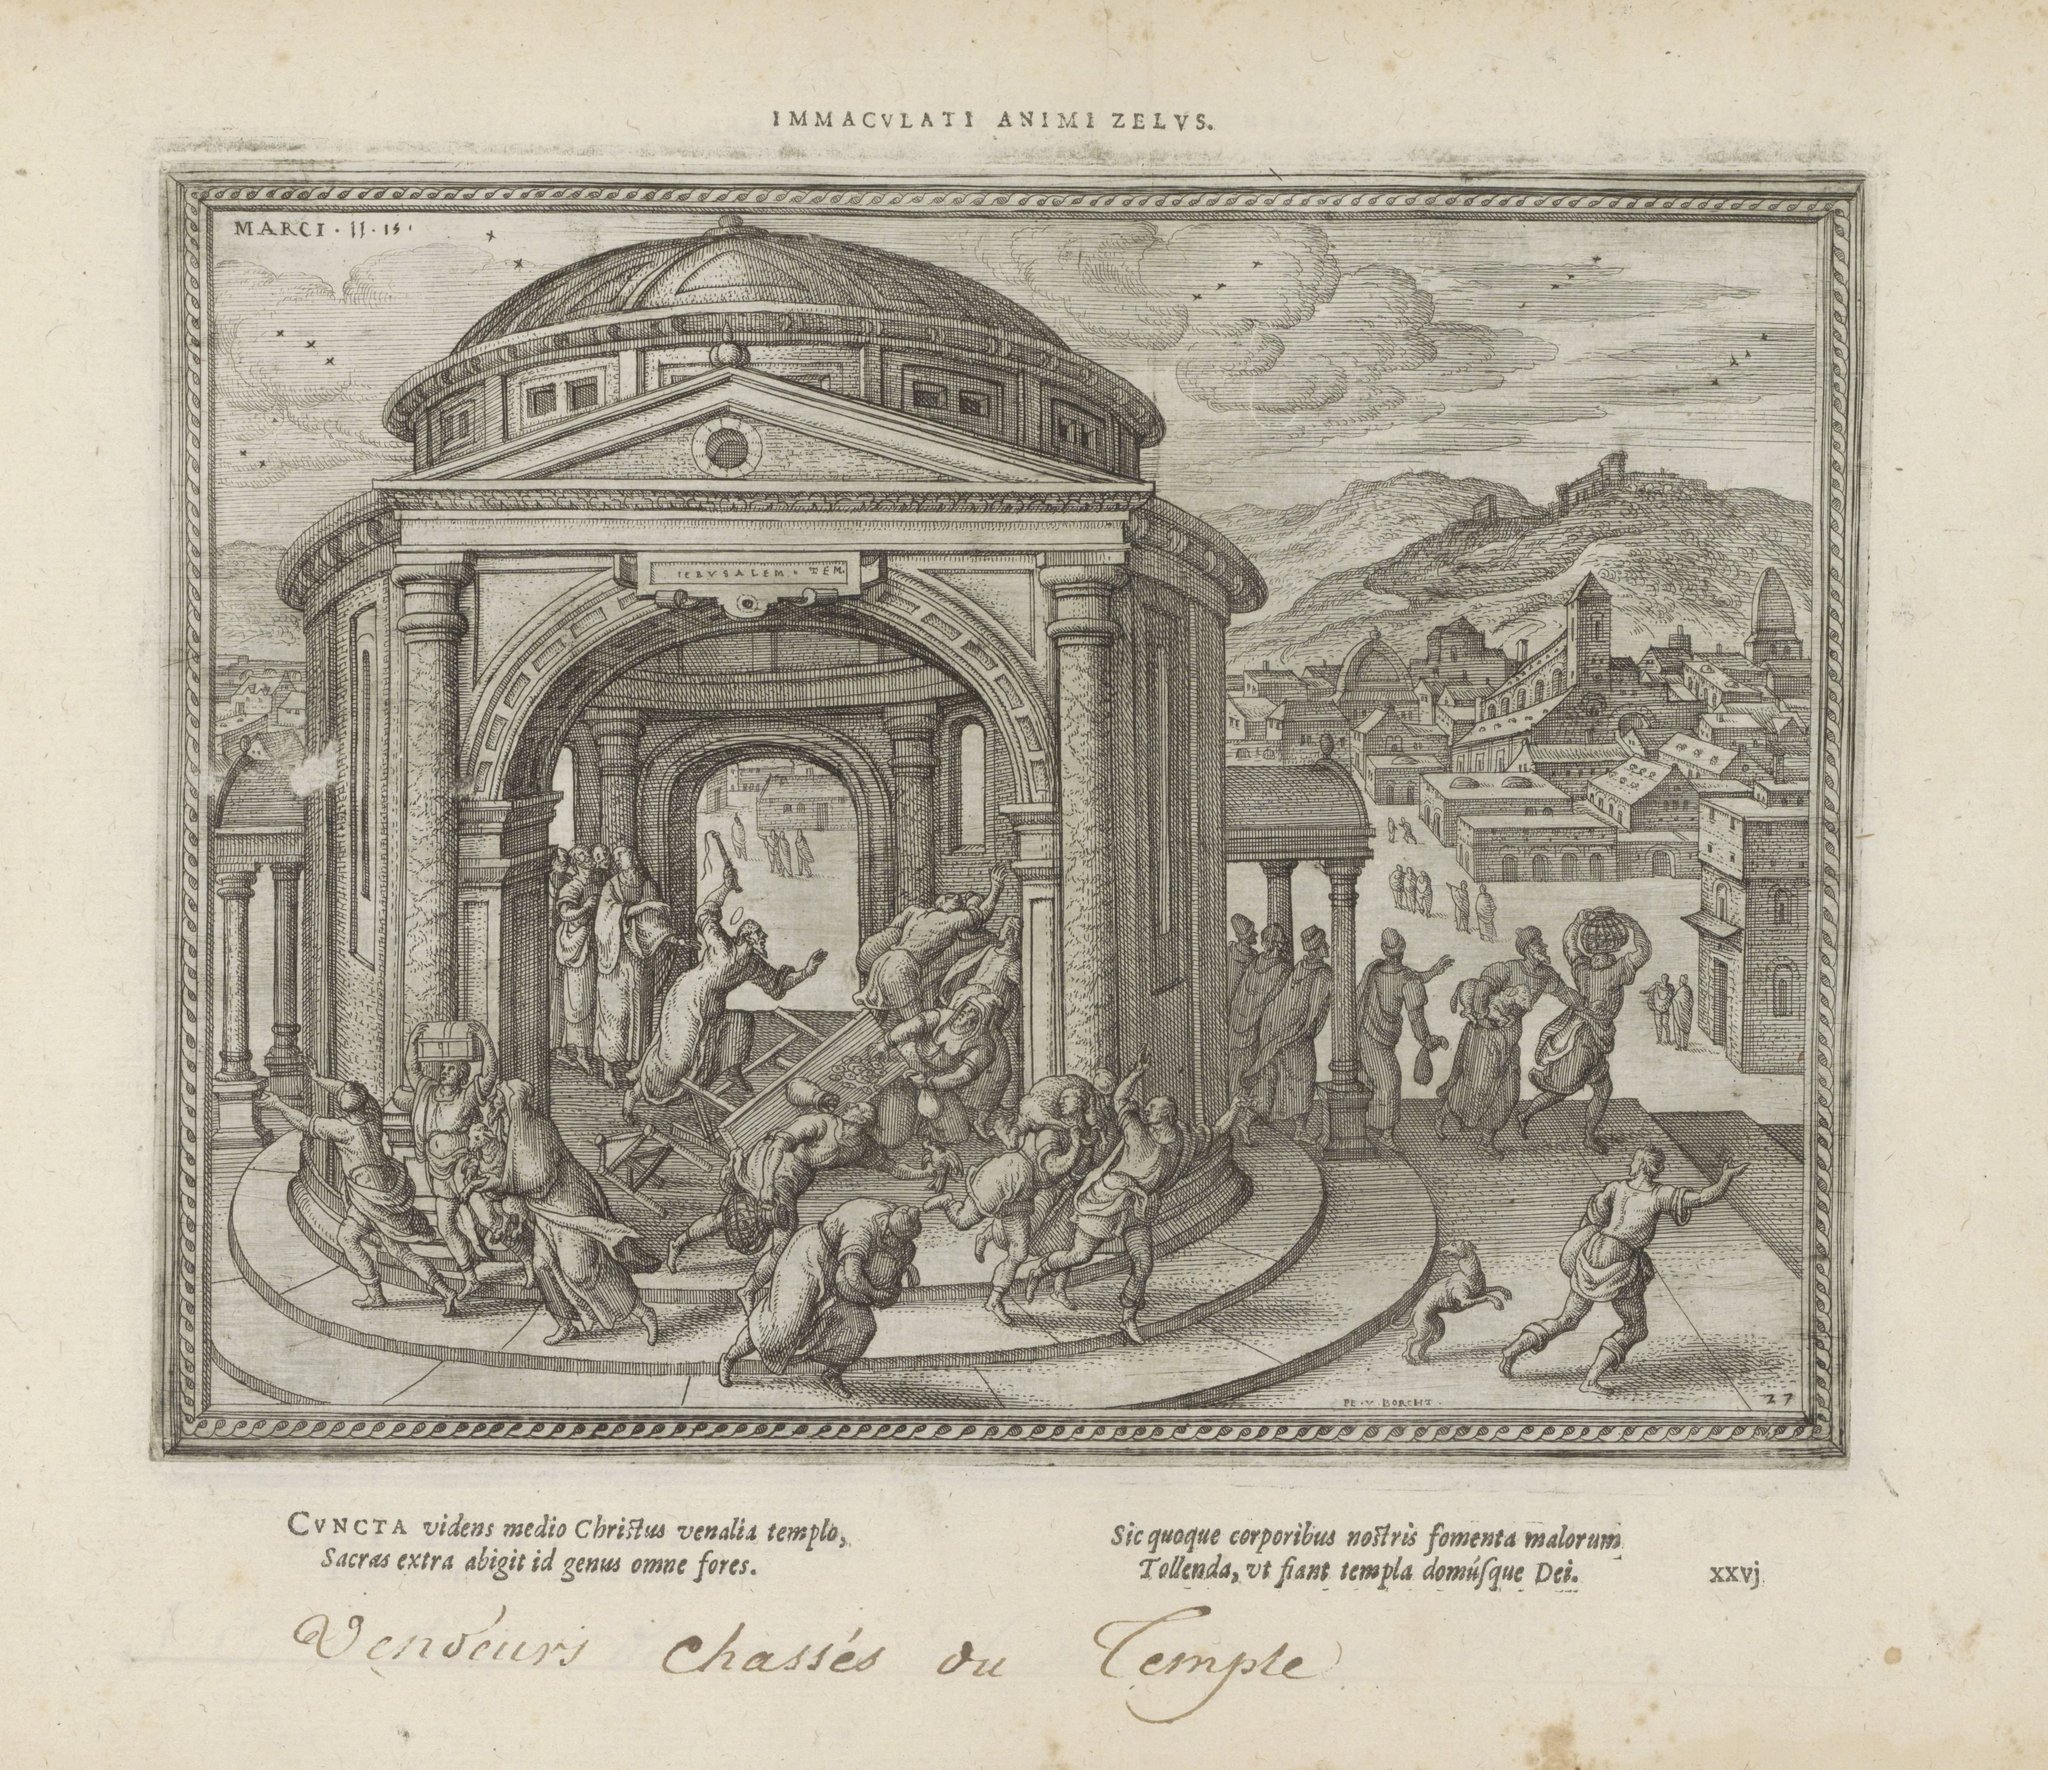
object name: album leaf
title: Imagines et figurae bibliorum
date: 1582-1593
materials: paper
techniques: etching, letterpress printing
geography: amsterdam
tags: purification of the temple ('first' and 'second'): christ driving the money-changers from the temple with a whip (matthew 21:12-13; mark 11:15-17; luke 19:45-46; john 12:12-19)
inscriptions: inscription: ‘Vendeurs chassés du Temple’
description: Christus jaagt met een zweep de geldwisselaars uit de tempel. Hij gooit hun tafels omver. Een man probeert in zijn vlucht nog geld van de tafel te pakken. Anderen vluchten met een schaap of dragen een kooi met duiven (Mar. 11:15). Met een motto in het Latijn boven de voorstelling en een vierregelig onderschrift in het Latijn onder de prent. De prent maakt deel uit van een album.